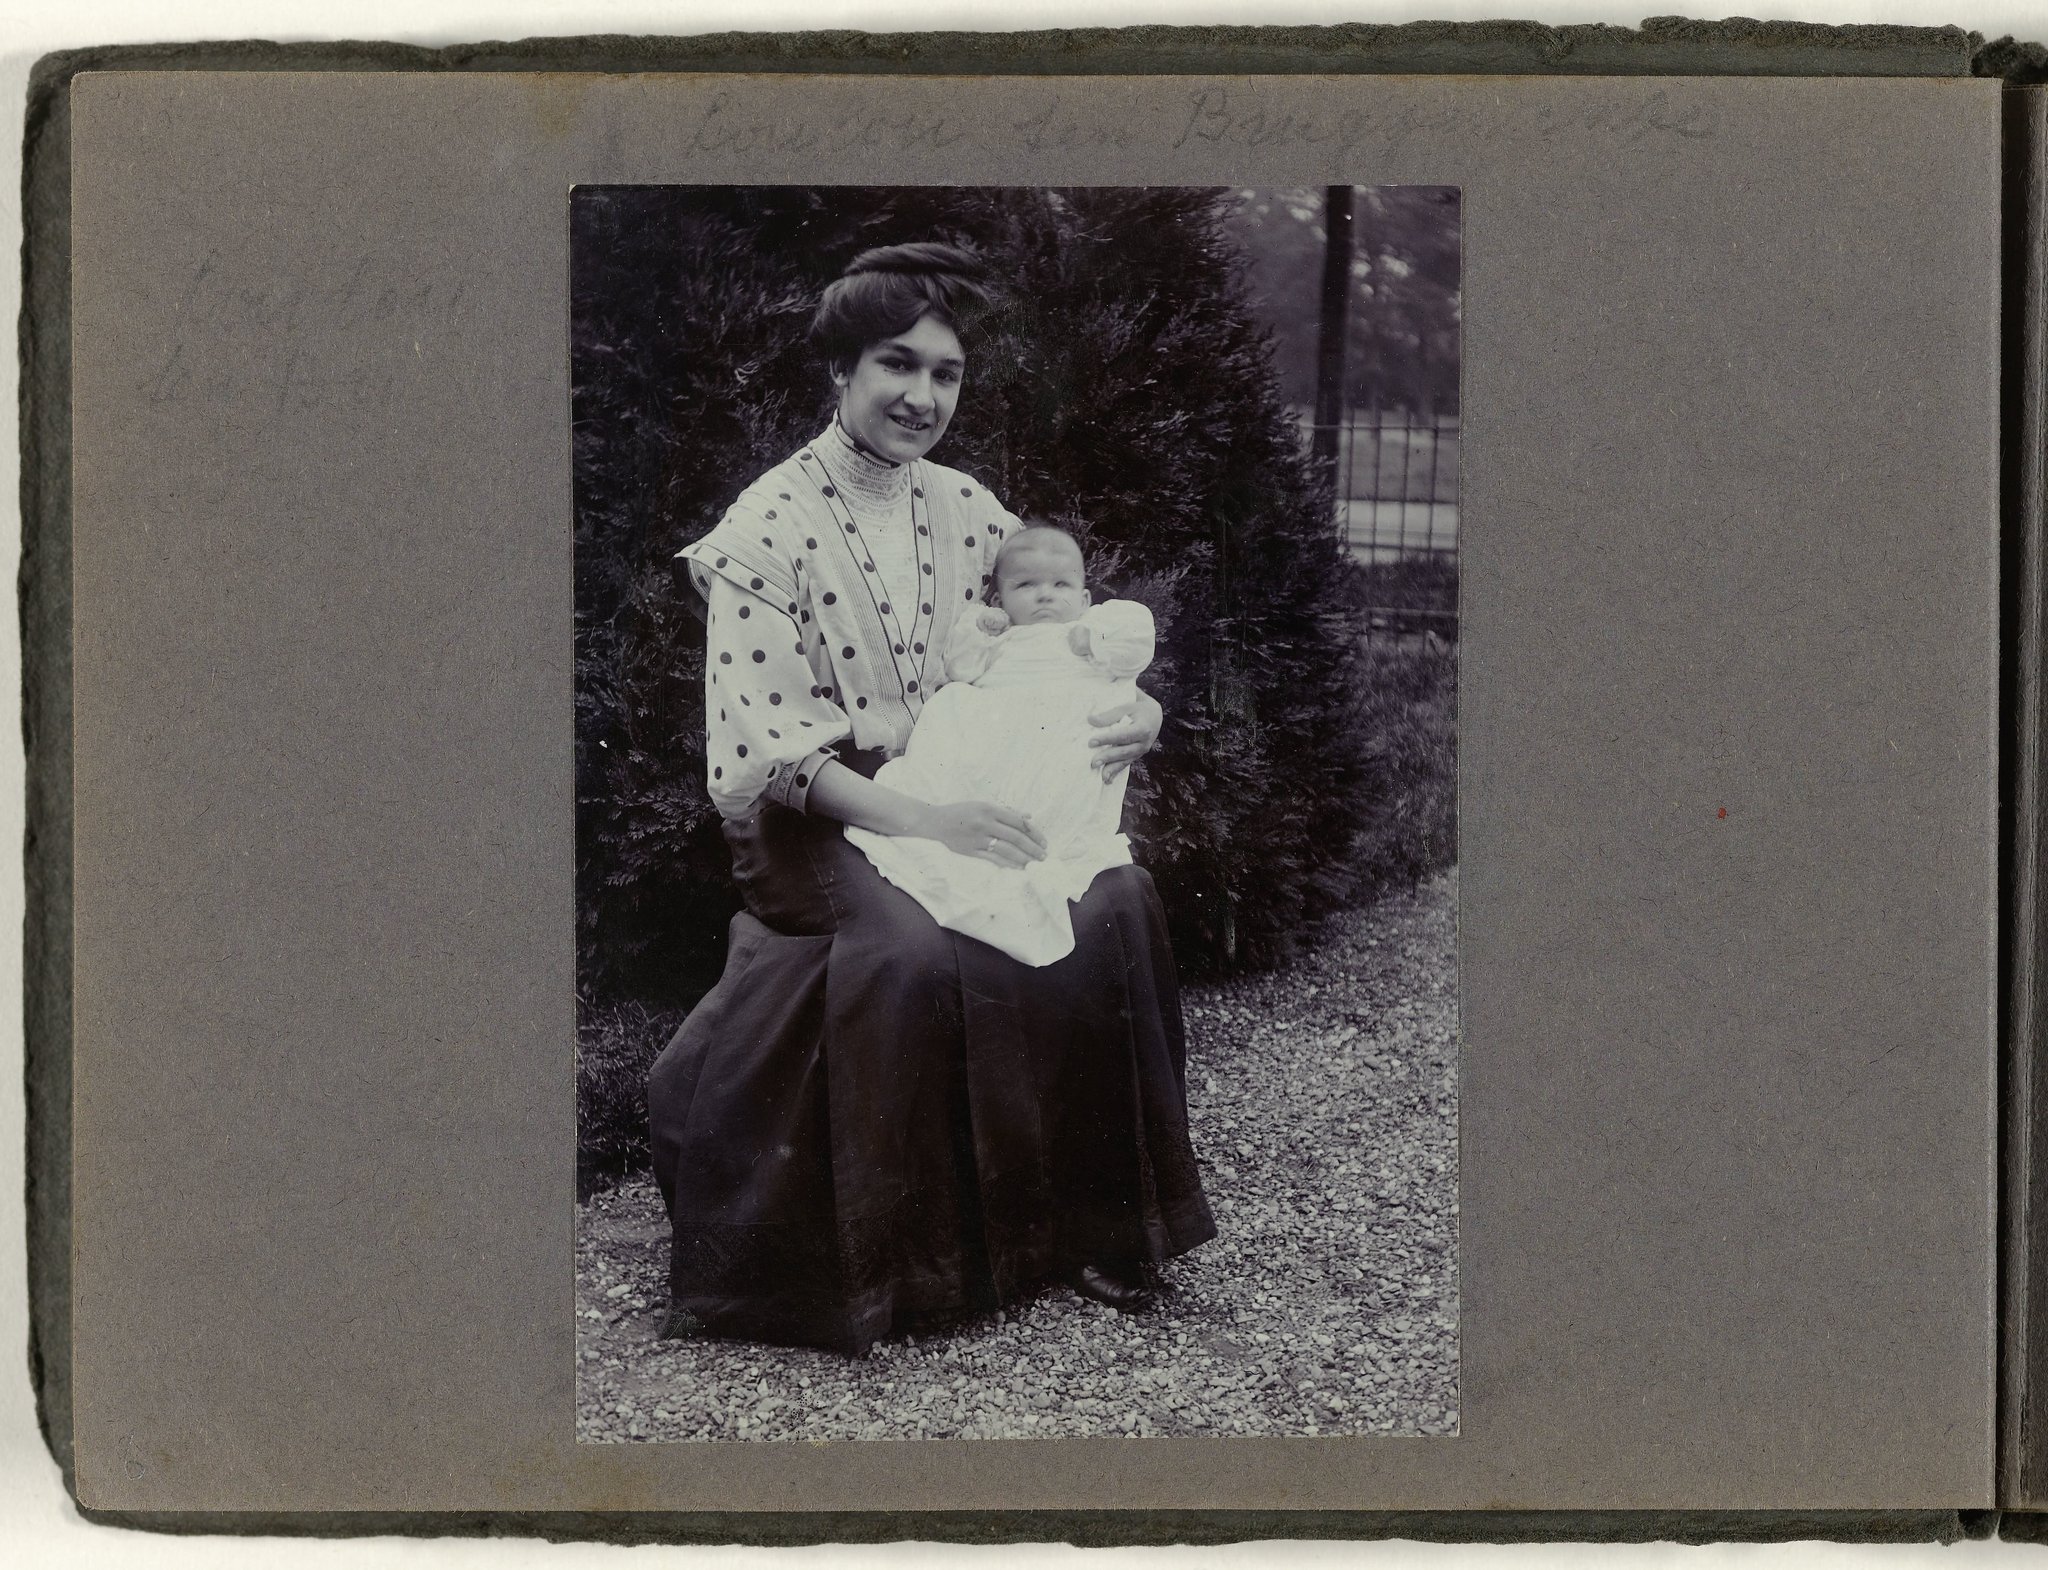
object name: photograph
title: Louise Ten Bruggencate-Gonggrijp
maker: Anonymous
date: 1910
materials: photographic support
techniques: gelatin silver print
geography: suriname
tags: suriname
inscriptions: inscription: ‘Loulou ten Bruggencate’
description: Portret van Louise Ten Bruggencate-Gonggrijp met een baby op schoot. Onderdeel van het fotoalbum over de familie Gonggrijp op de plantages Clevia en Morgenstond in Suriname rond 1910.